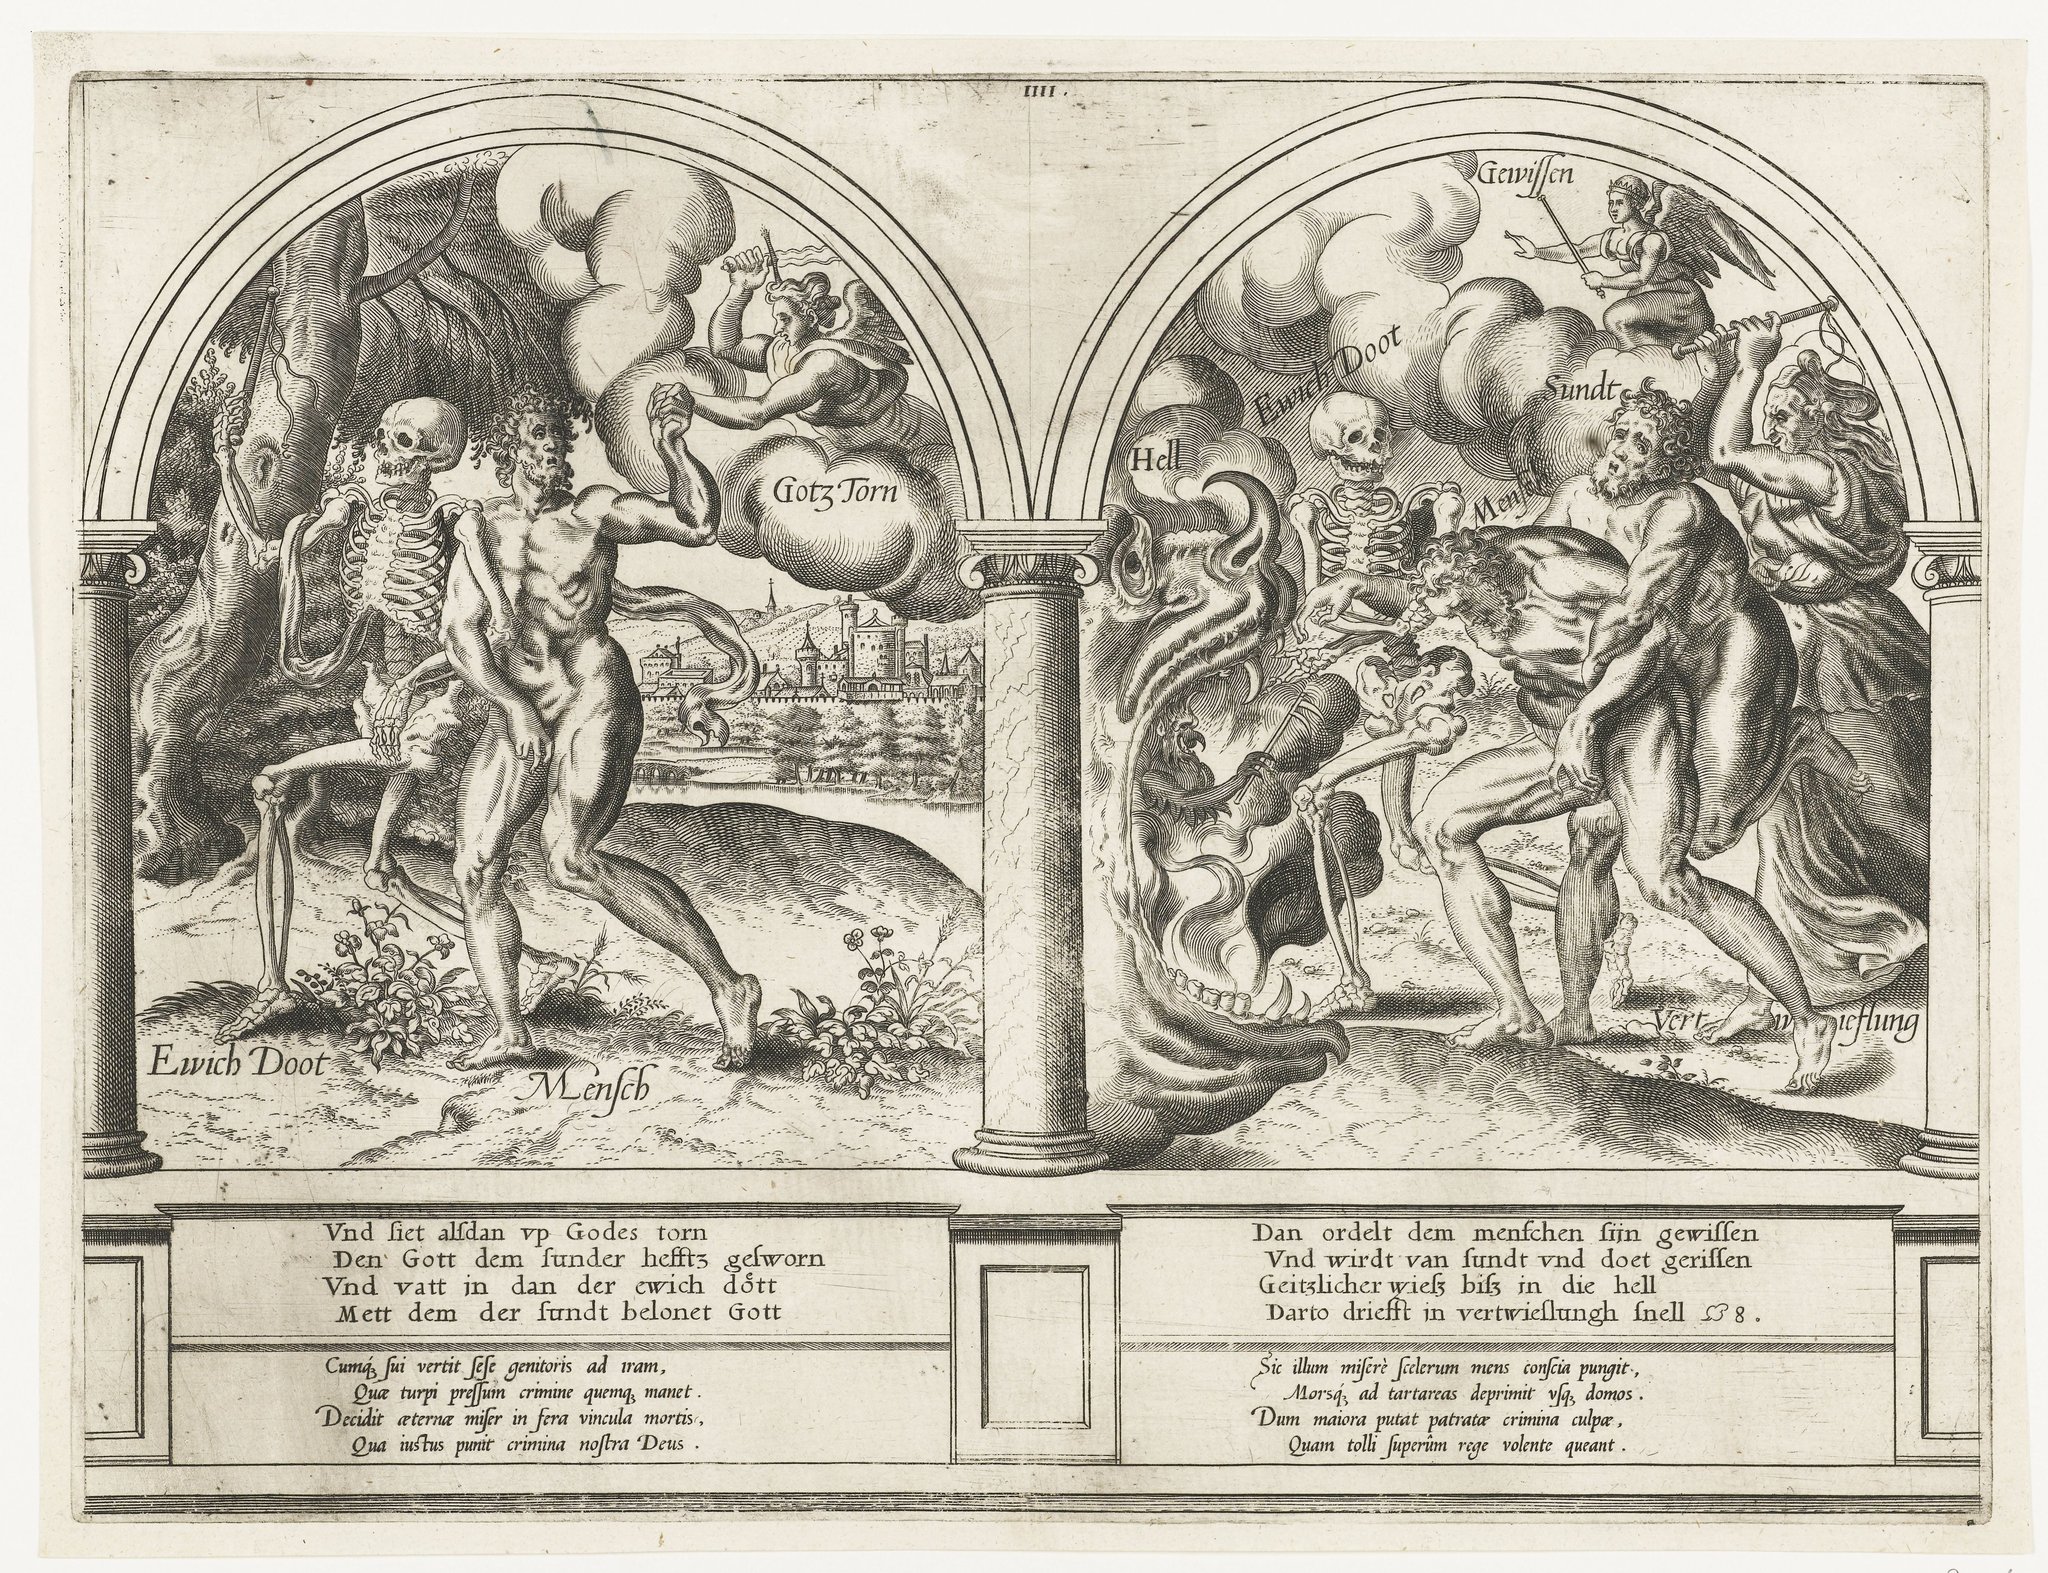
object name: print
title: De zondige Mens door Gods toorn tot de hel gedreven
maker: frans huys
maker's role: print maker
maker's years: 1522-1562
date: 1546-1562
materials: paper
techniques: engraving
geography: antwerp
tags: death as skeleton, despair; 'disperatione' (ripa), vice, evil, sin; 'peccato' (ripa), doctrine on original sin, and redemption, god's wrath, conscience; 'coscienza' (ripa) (+ clothed with wings)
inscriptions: collector's mark: Lugt 2760, collector's mark: Lugt 2228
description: Twee bijbelse allegorieën in architecturale omlijsting. Links wordt de Mens door de personificatie van de Eeuwige Dood aan de arm meegenomen, terwijl de personificatie van Gods toorn op de wolken zijn andere hand vasthoudt. De Eeuwige Dood, als Gods straf voor de zonde, voert de Mens naar de hellemond, terwijl hij door de personificaties van de Zonde, Geweten en Vertwijfeling wordt gedreven. Onder beide voorstellingen een vierregelig vers in het Nederduits en een vierregelige tekst in het Latijn. De voorstelling rechts is genummerd: 8. Prent uit een reformatorische serie over de zondigheid en rechtvaardiging van de mens.